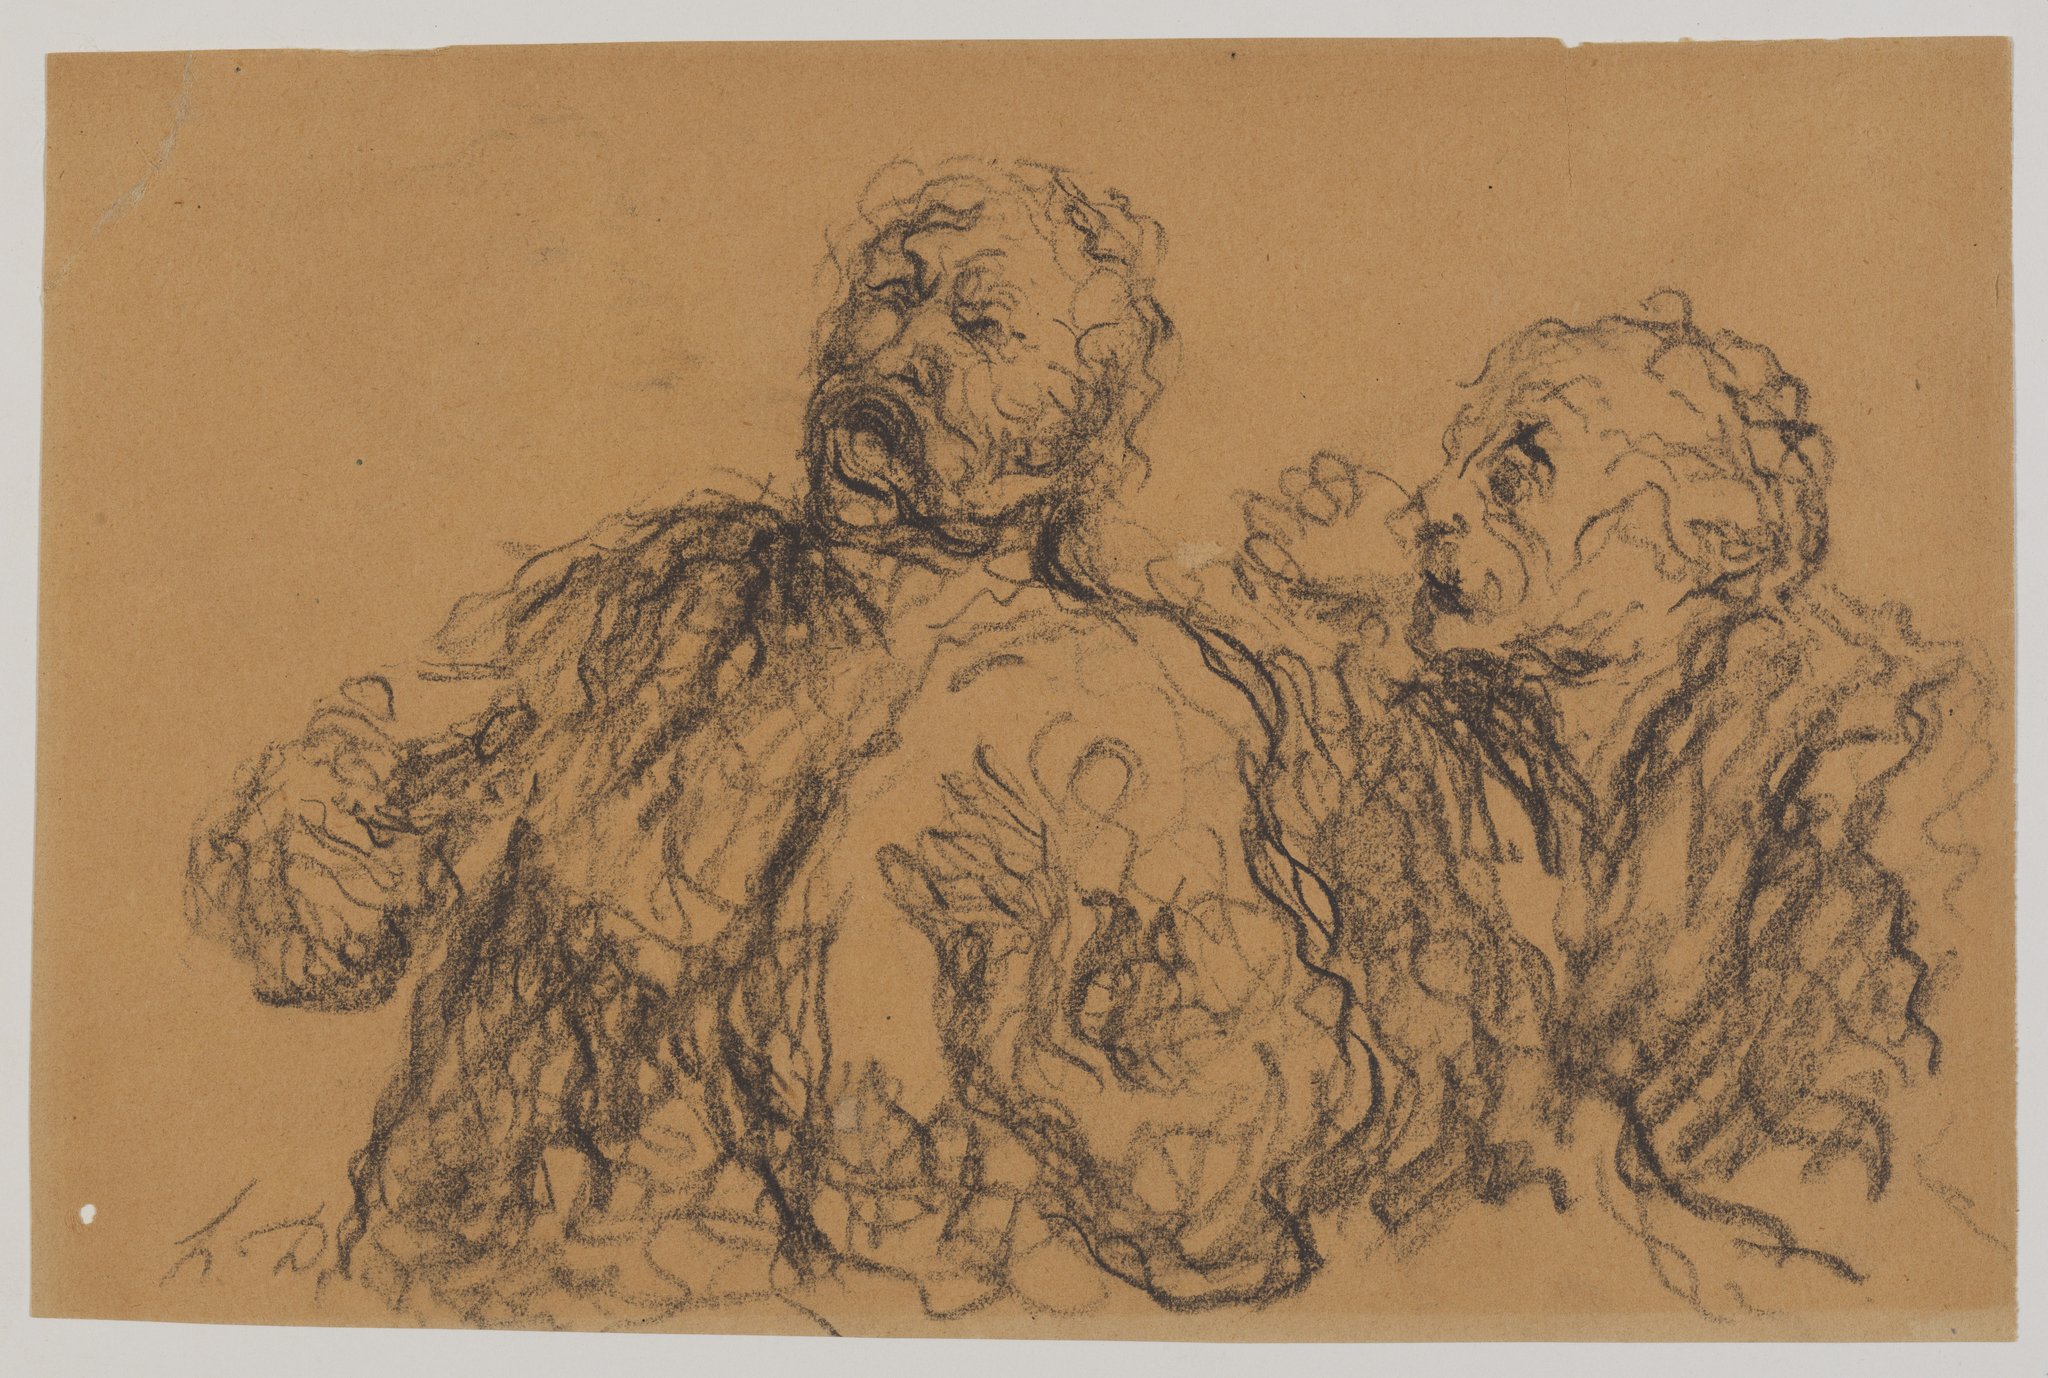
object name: drawing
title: Two Drinkers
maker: honoré daumier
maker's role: artist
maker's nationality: french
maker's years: 1808-1879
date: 1834-1866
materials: chalk, paper